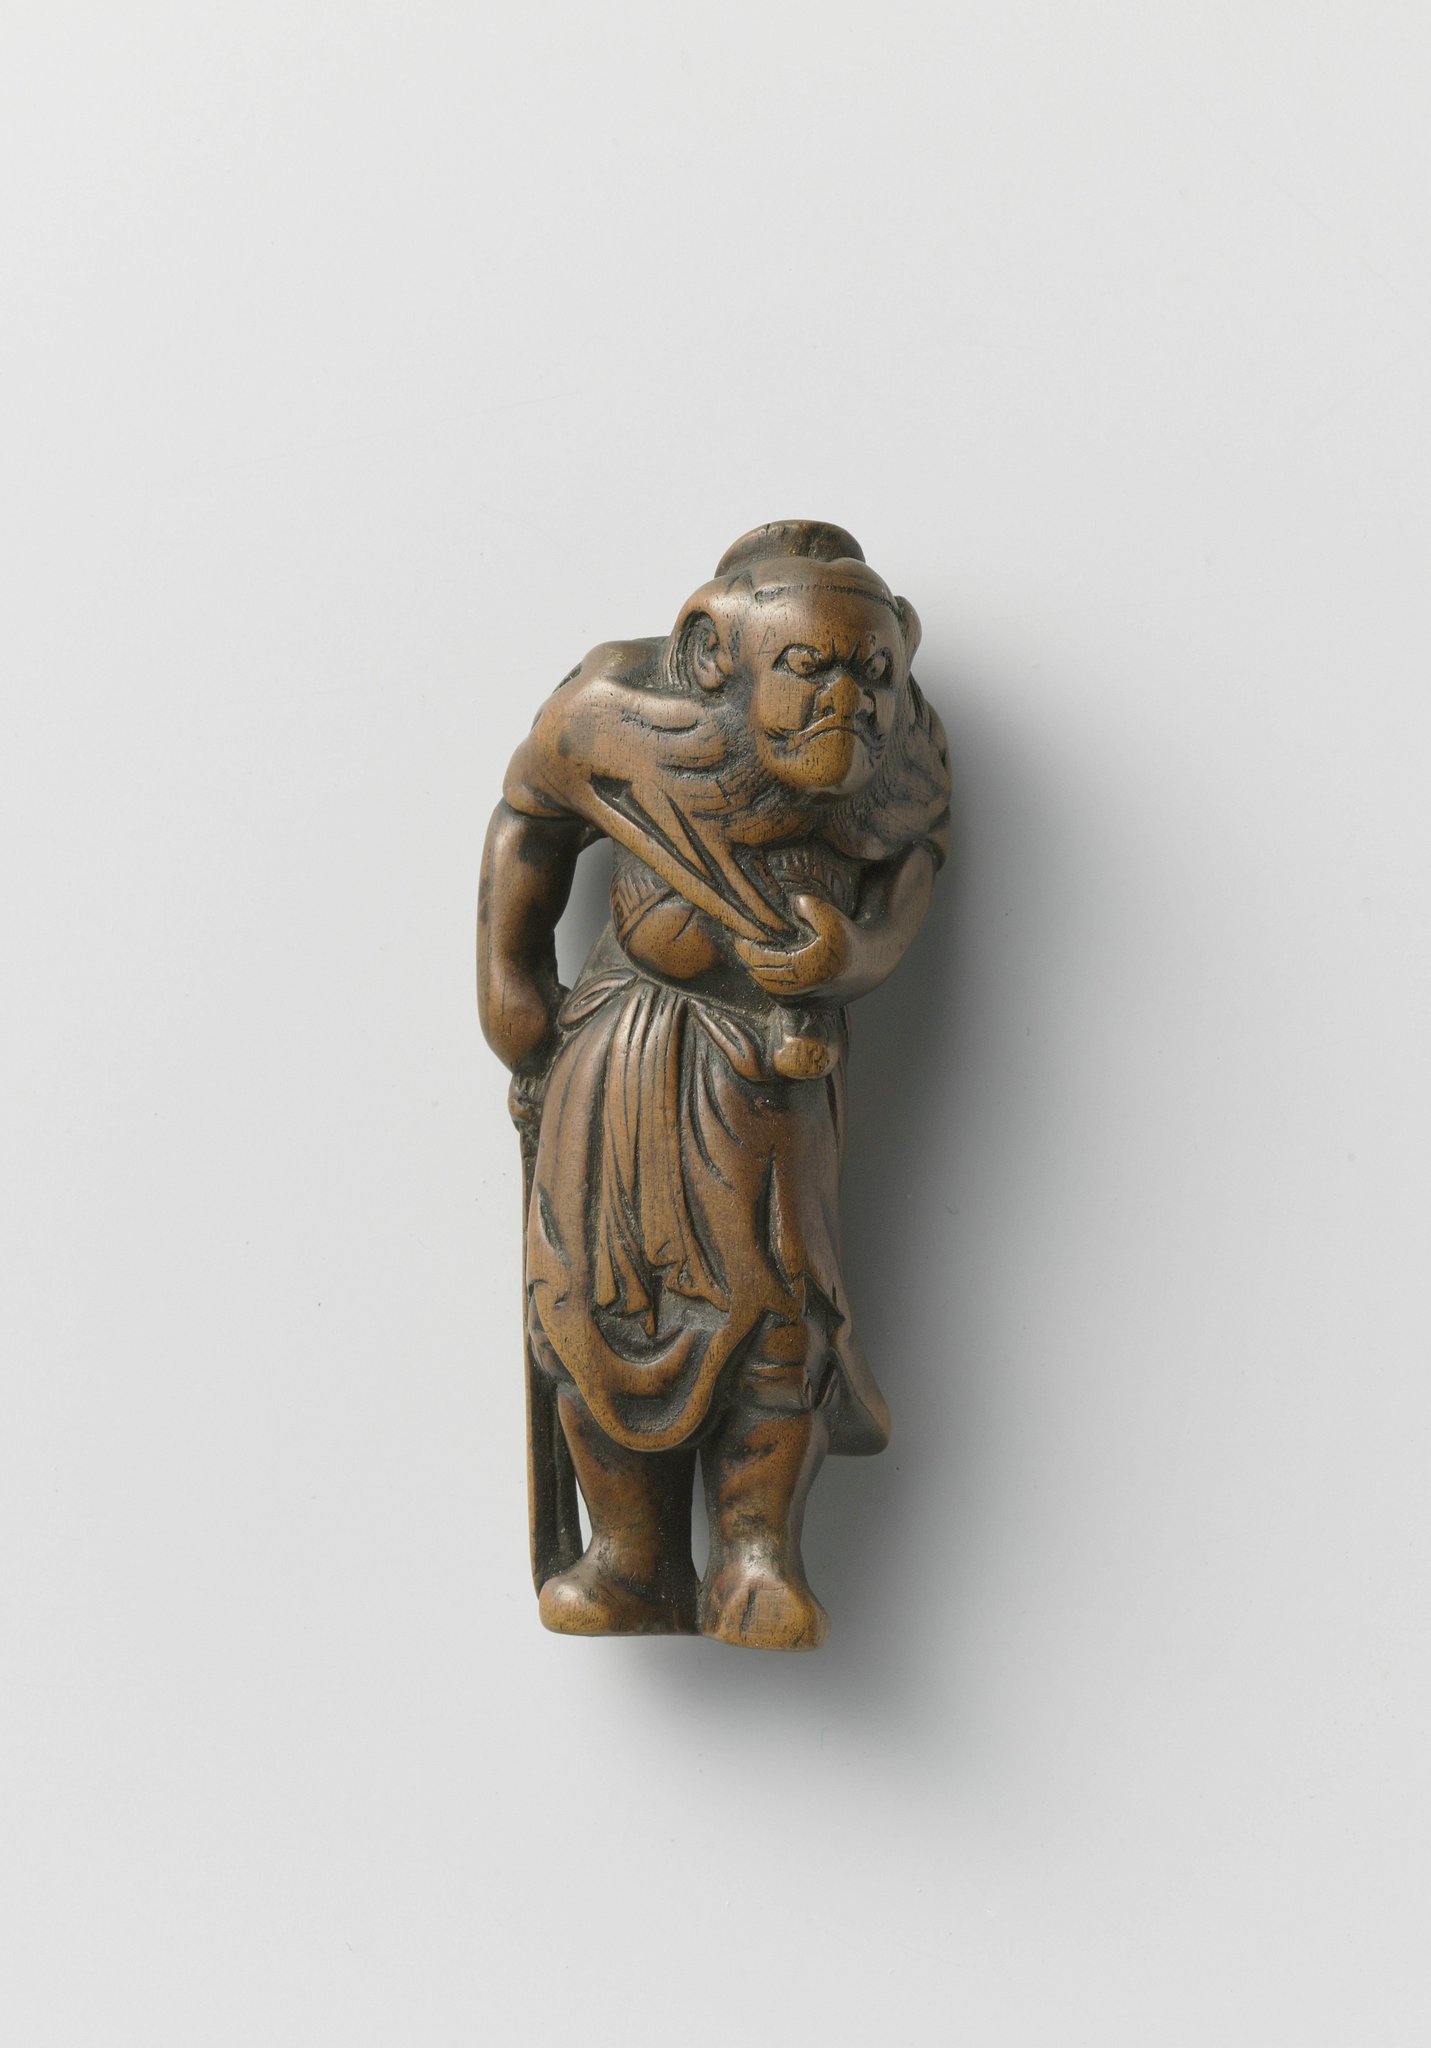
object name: netsuke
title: Netsuke, Shoki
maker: Anonymous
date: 1850-1900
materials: wood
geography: japan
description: Shoki, de geestenverdrijver. Gesigneerd "masakazu".